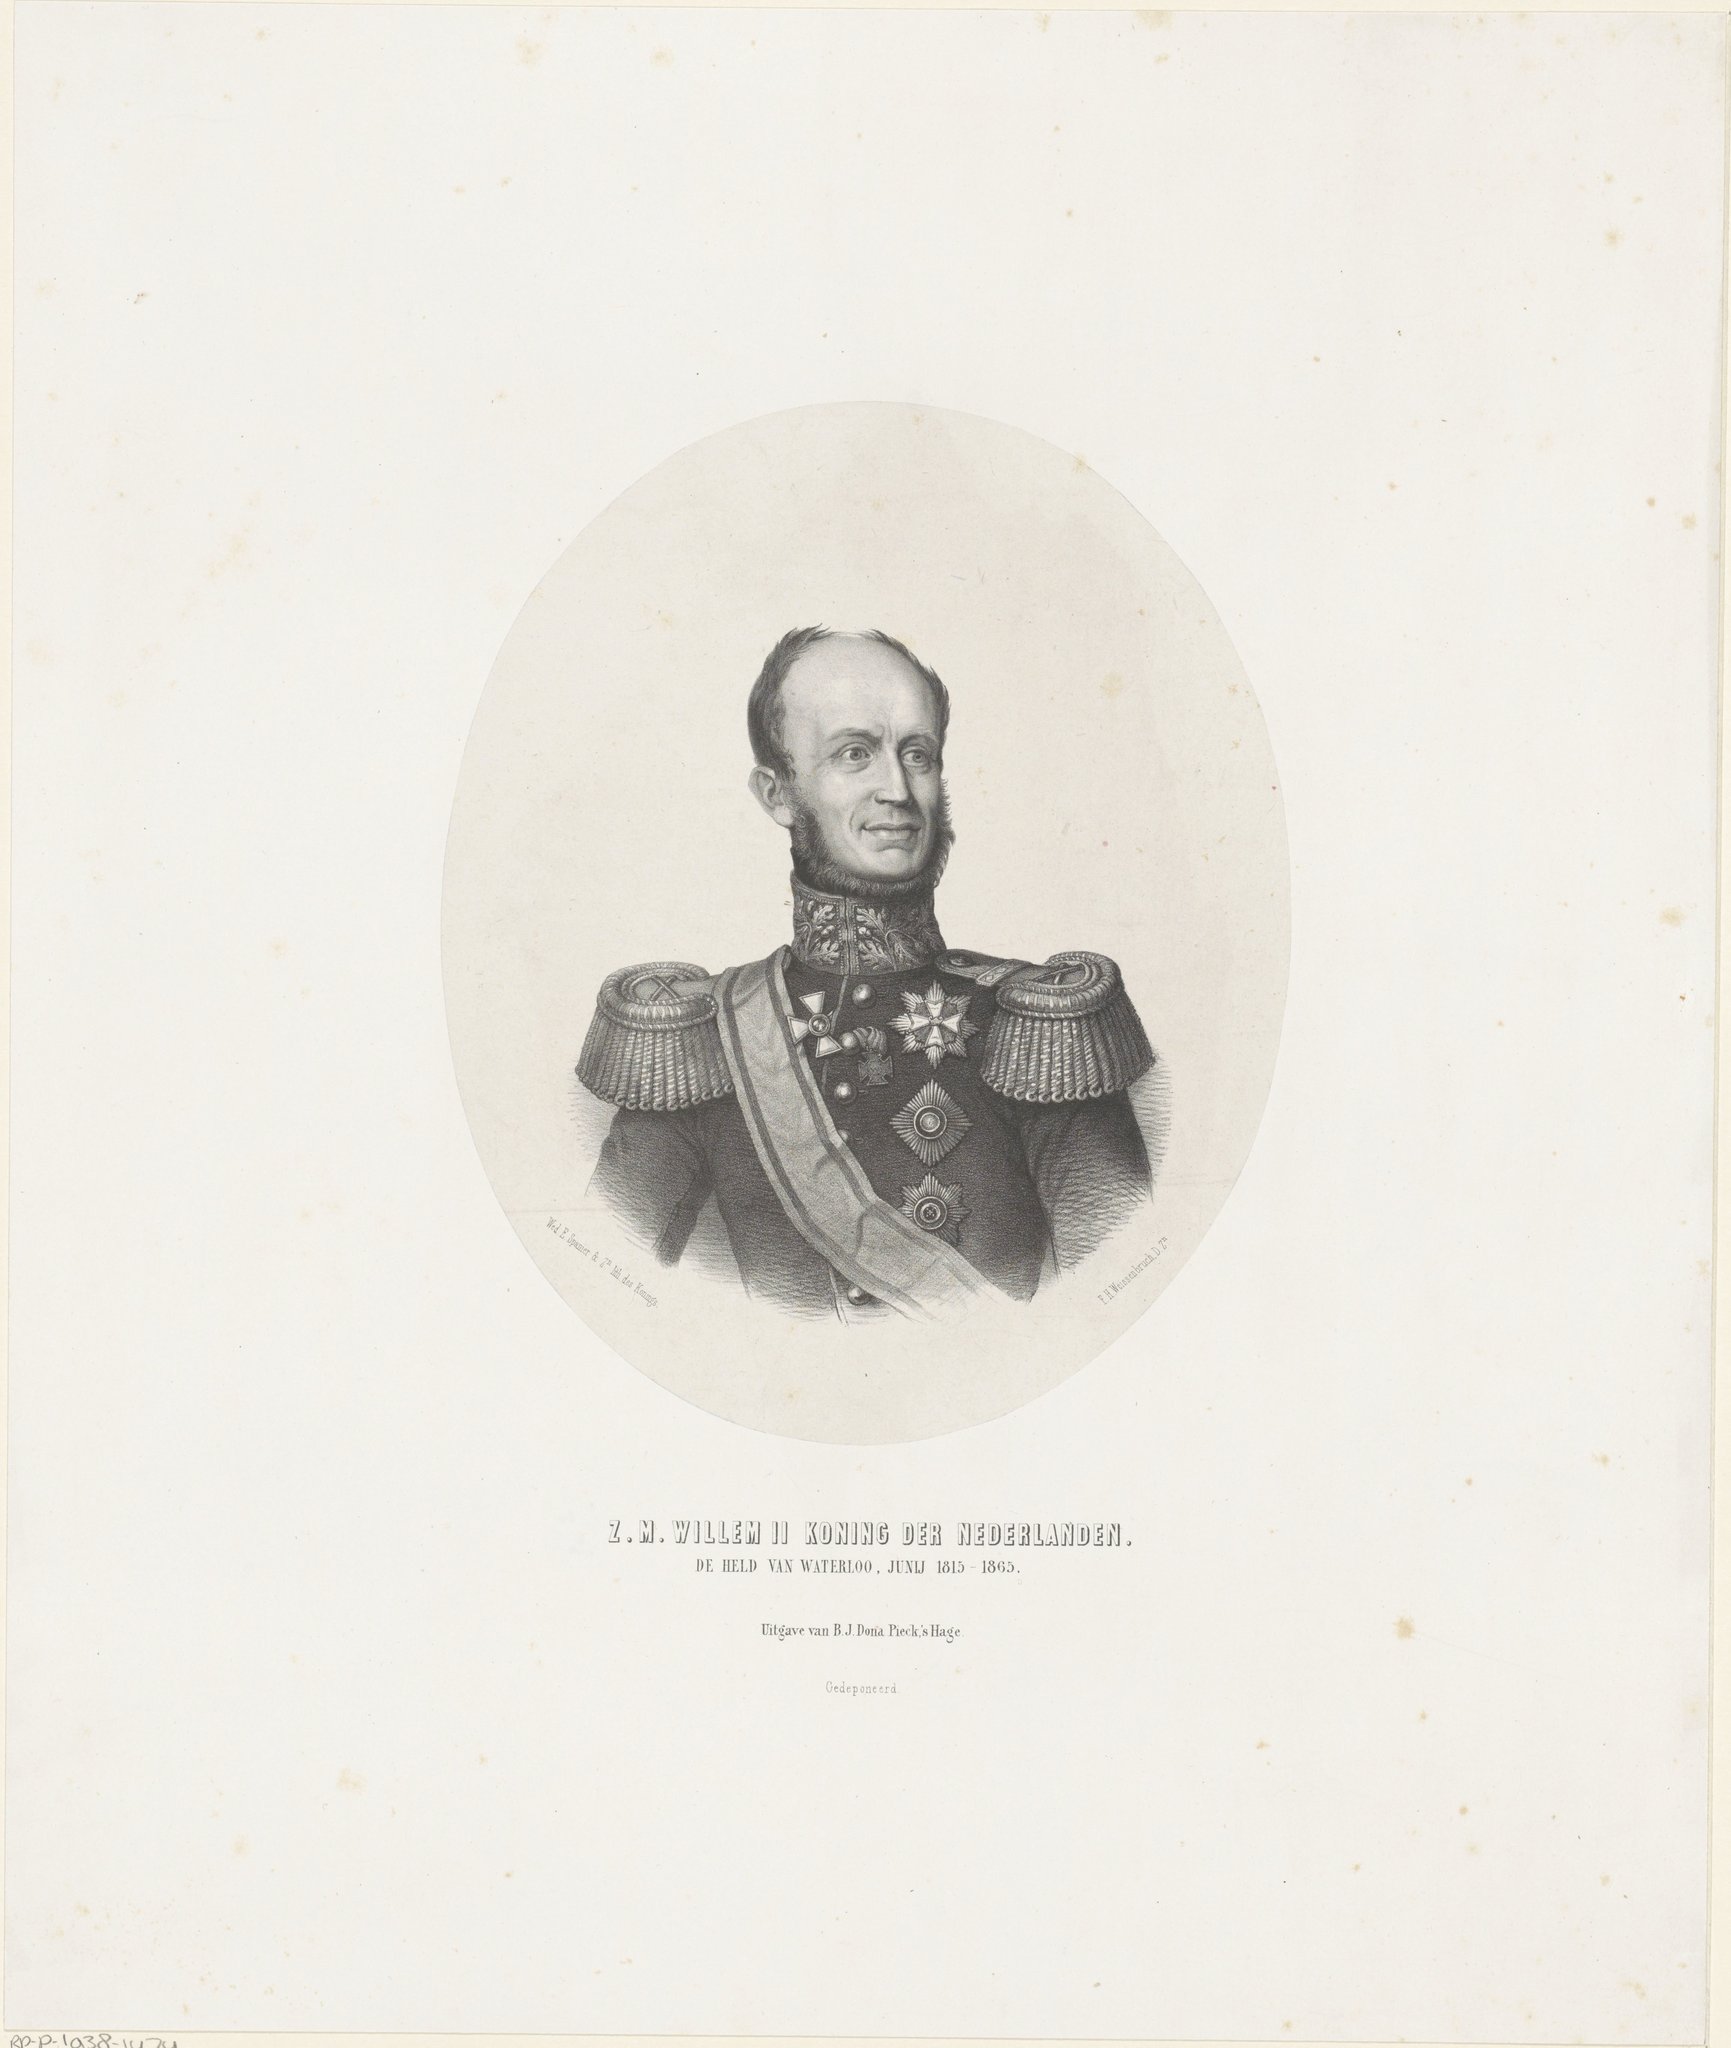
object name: print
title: Portret van Willem II, koning der Nederlanden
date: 1865-1884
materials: paper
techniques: lithograph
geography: the hague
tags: the hague, william ii of the netherlands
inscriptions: collector's mark: Lugt 2228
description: De hier vermelde titel verwijst naar de hoogst verkregen titel van de geportretteerde, niet per se naar de titel die de geportretteerde op deze voorstelling draagt.